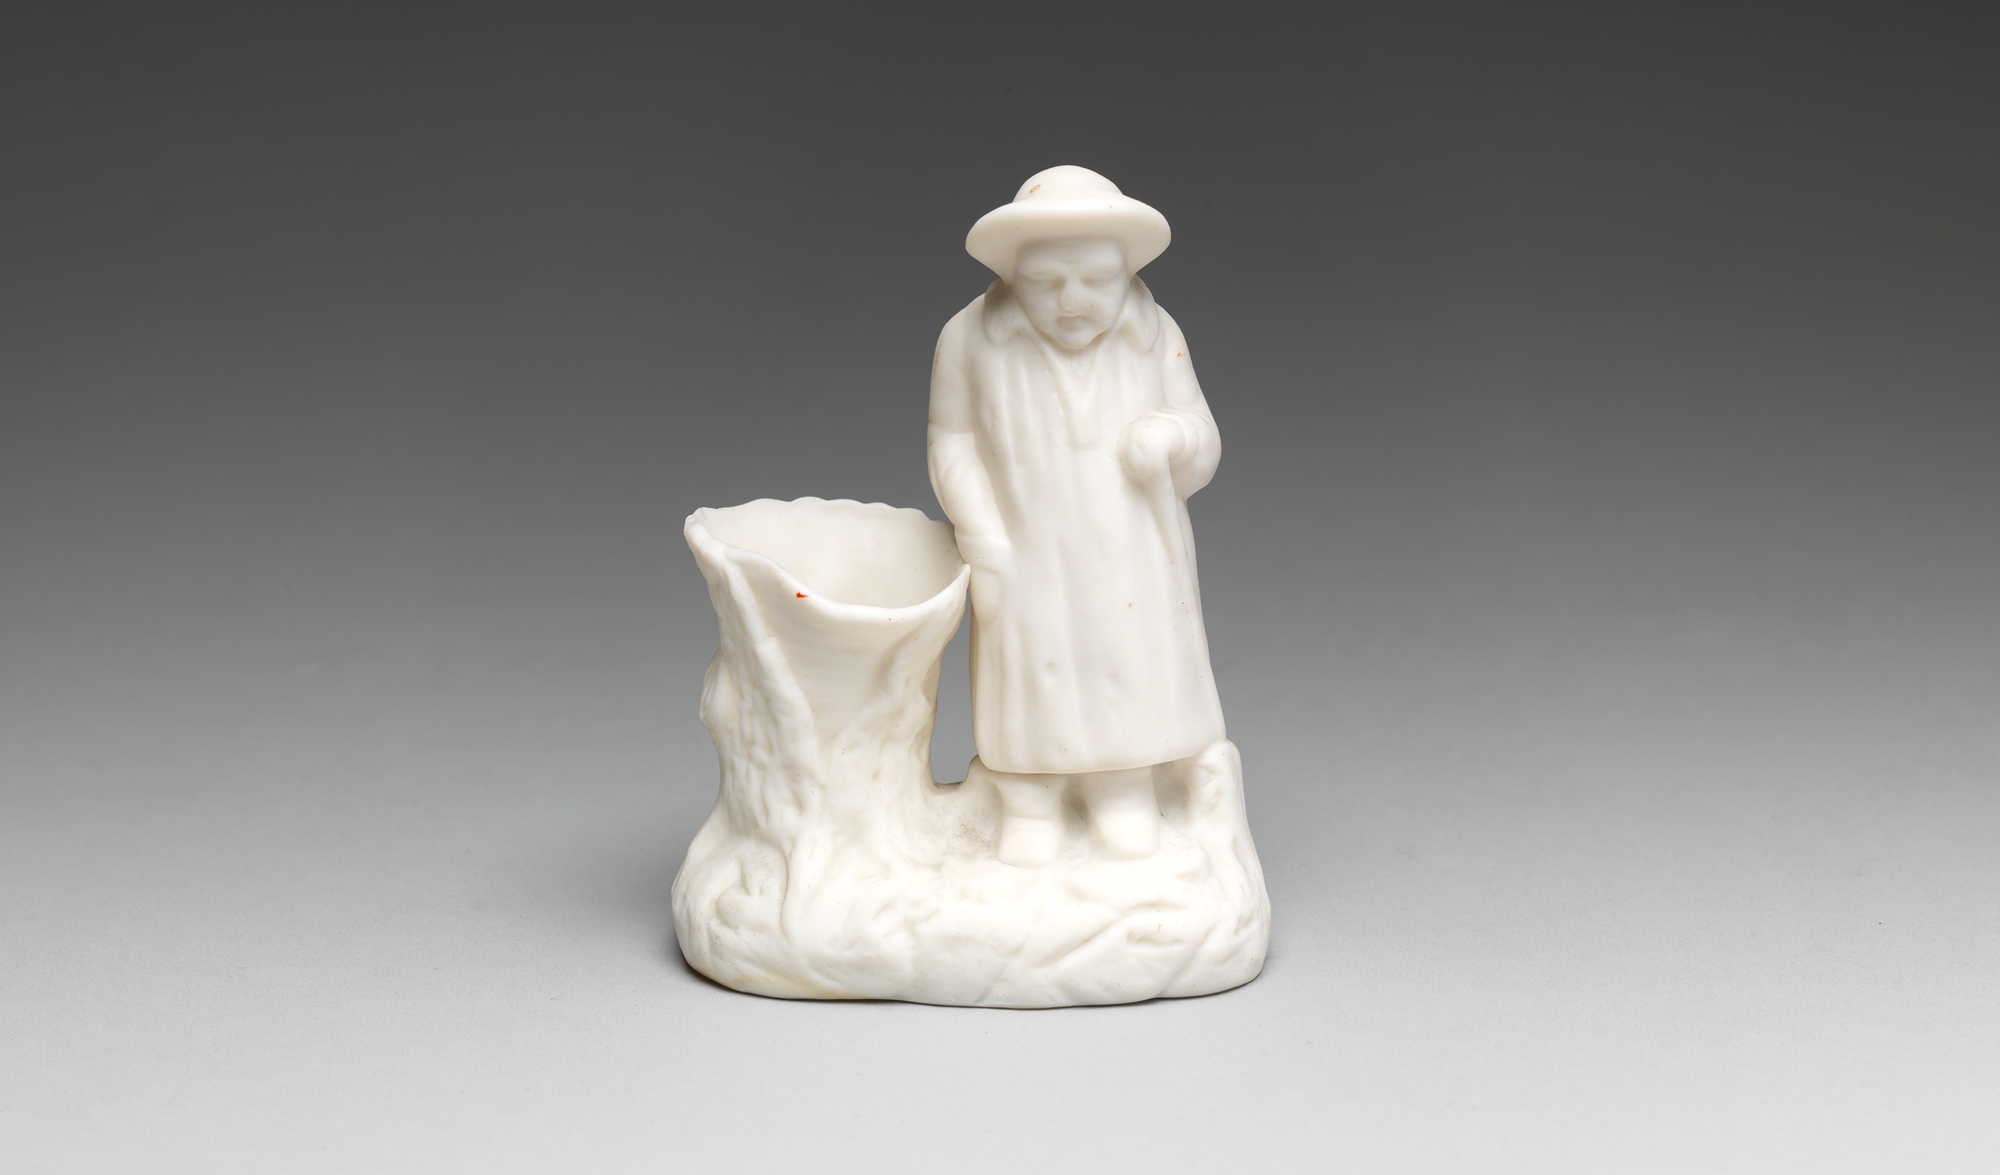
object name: matchsafe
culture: american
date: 1830-1870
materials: porcelain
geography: united states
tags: men